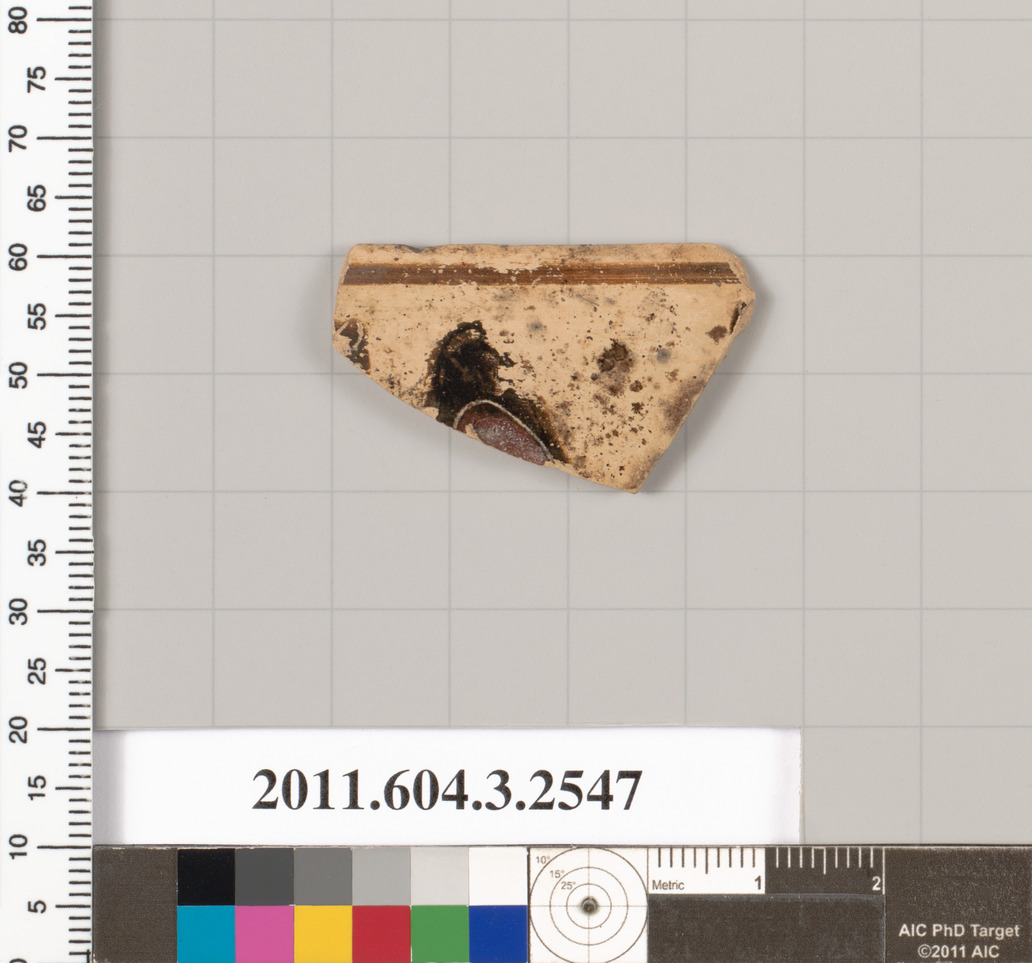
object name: kylix fragment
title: Terracotta rim fragment of a kylix (drinking cup)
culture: greek, attic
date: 534-468 BCE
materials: terracotta